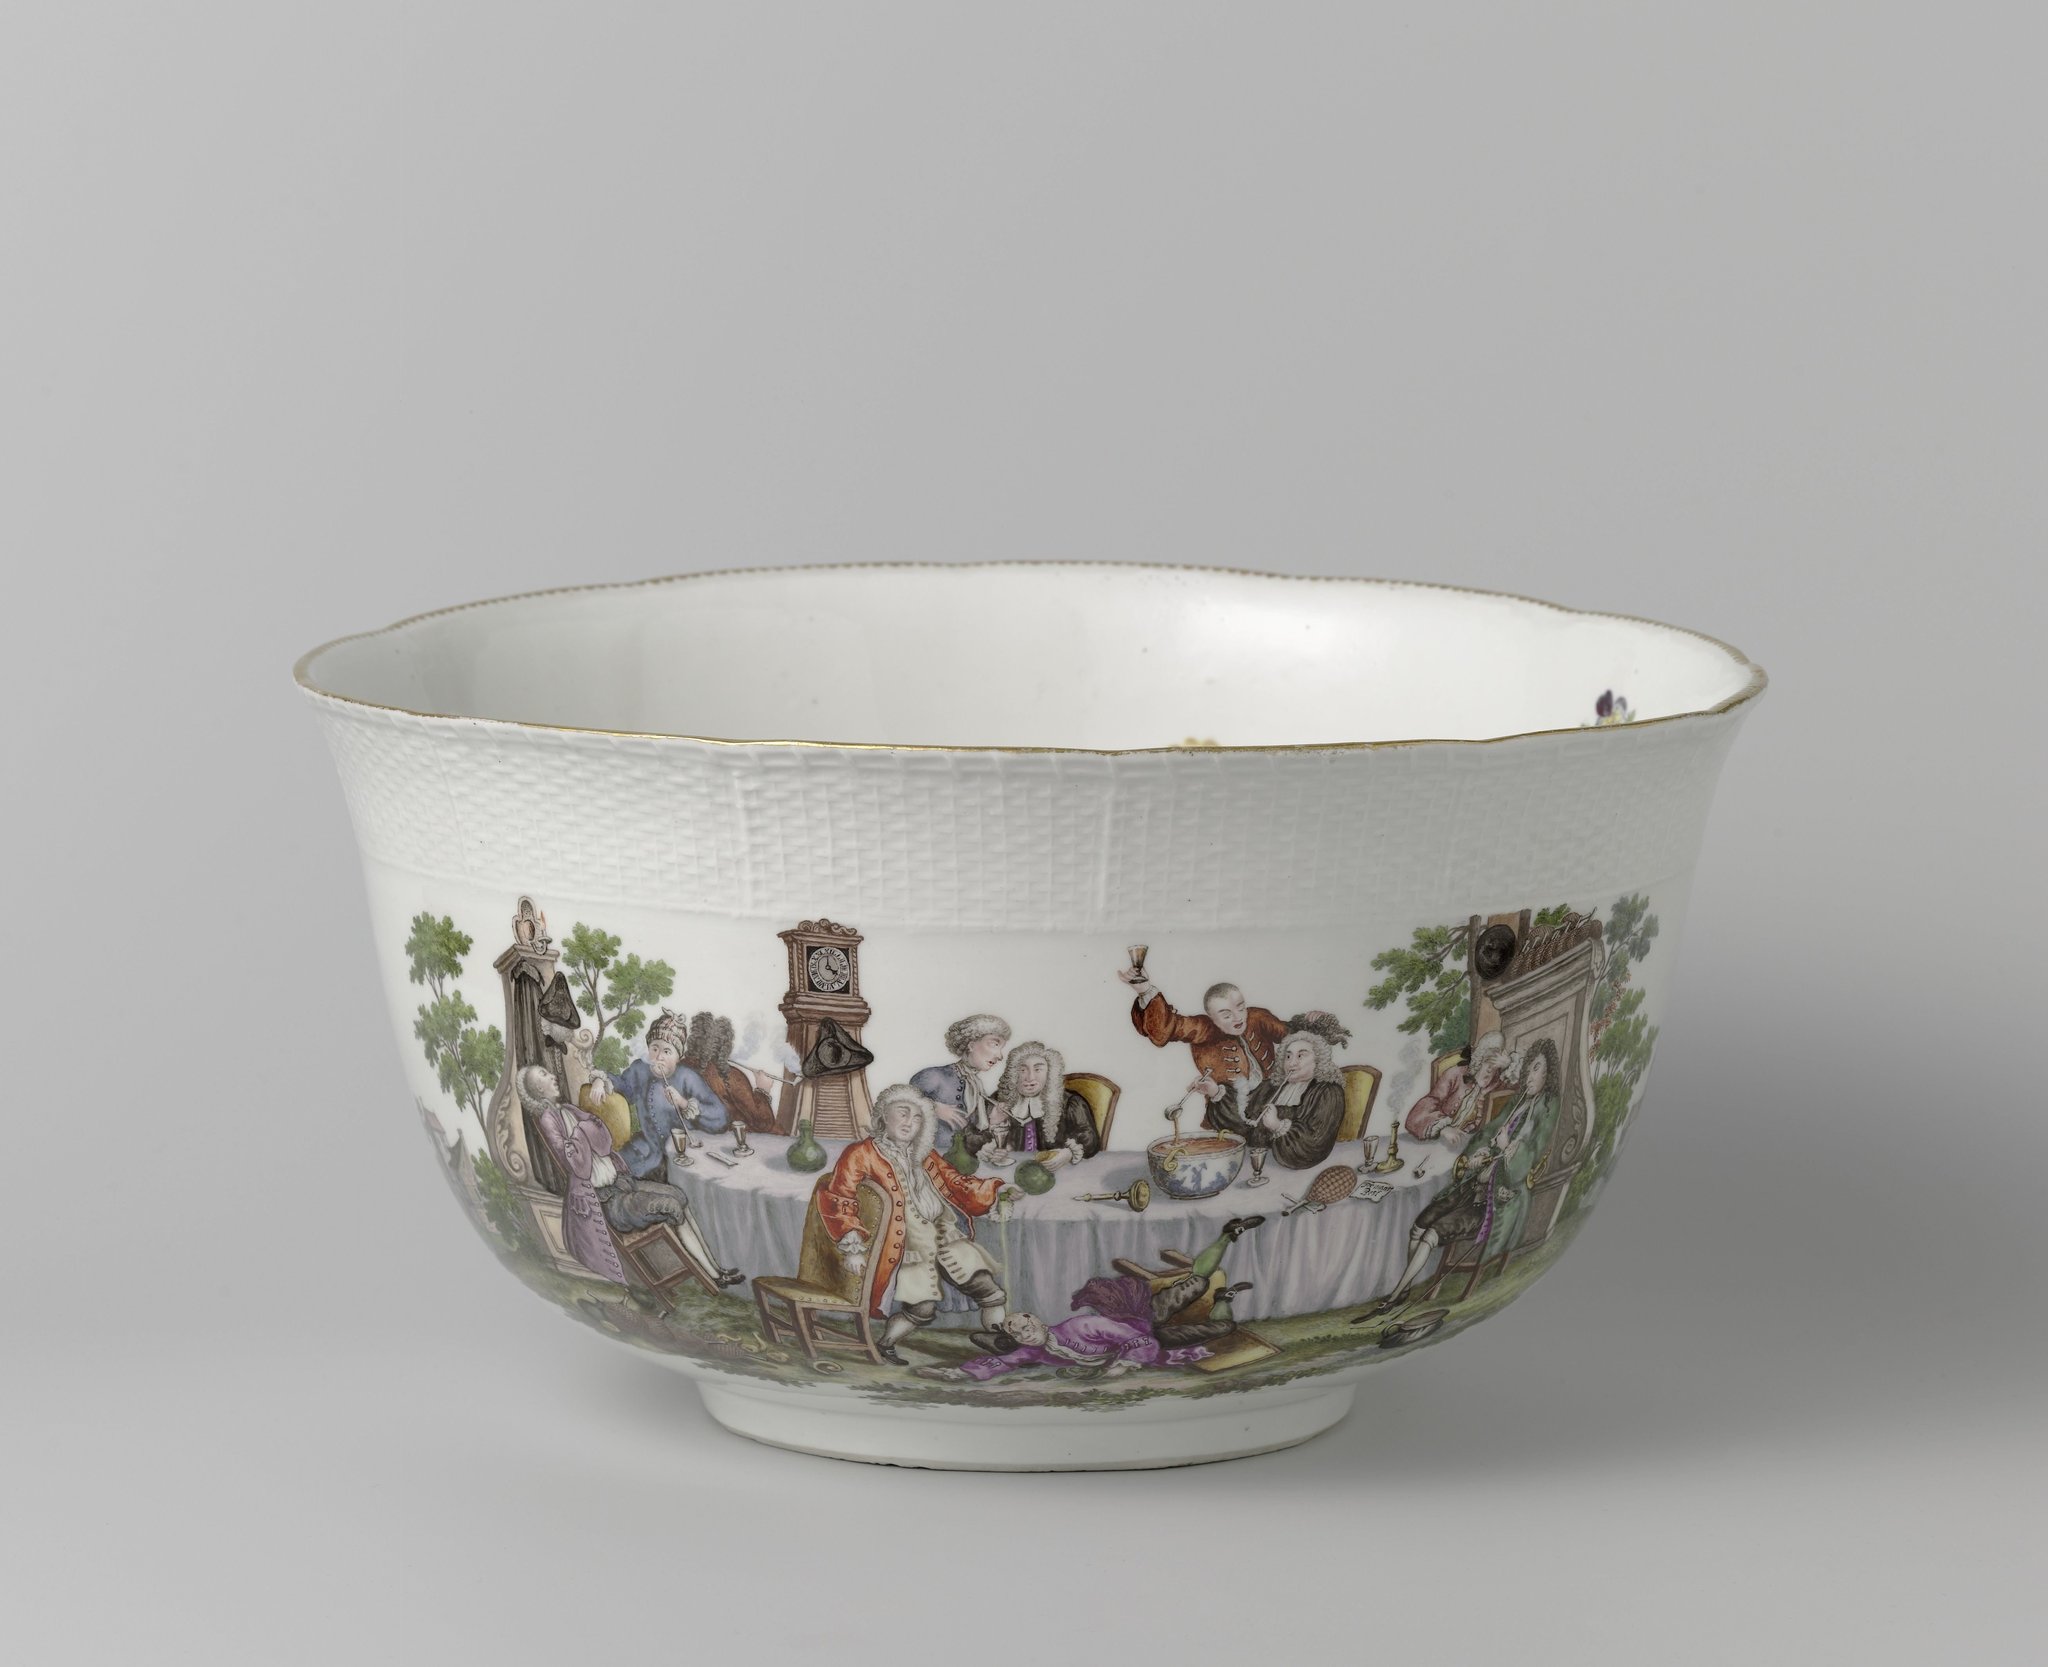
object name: bowl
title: Bowl, with a depiction of ‘A Midnight Modern Conversation’ by William Hogarth (1697-1764)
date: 1760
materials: porcelain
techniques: painted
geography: meissen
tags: serving-dish, platter, carousal, drinking-bout, orgy, drunkenness, falling, tobacco (+ taking (particular) foodstuffs: eating, drinking, smoking, chewing, etc.), drinking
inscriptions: factory mark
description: By copying Hogarth’s A Midnight Modern Conversation on a punchbowl, an illusion of infinity is created, as it were (a scene within a scene within a scene, etc). After all, a comparable punchbowl features on the table in the scene depicted.